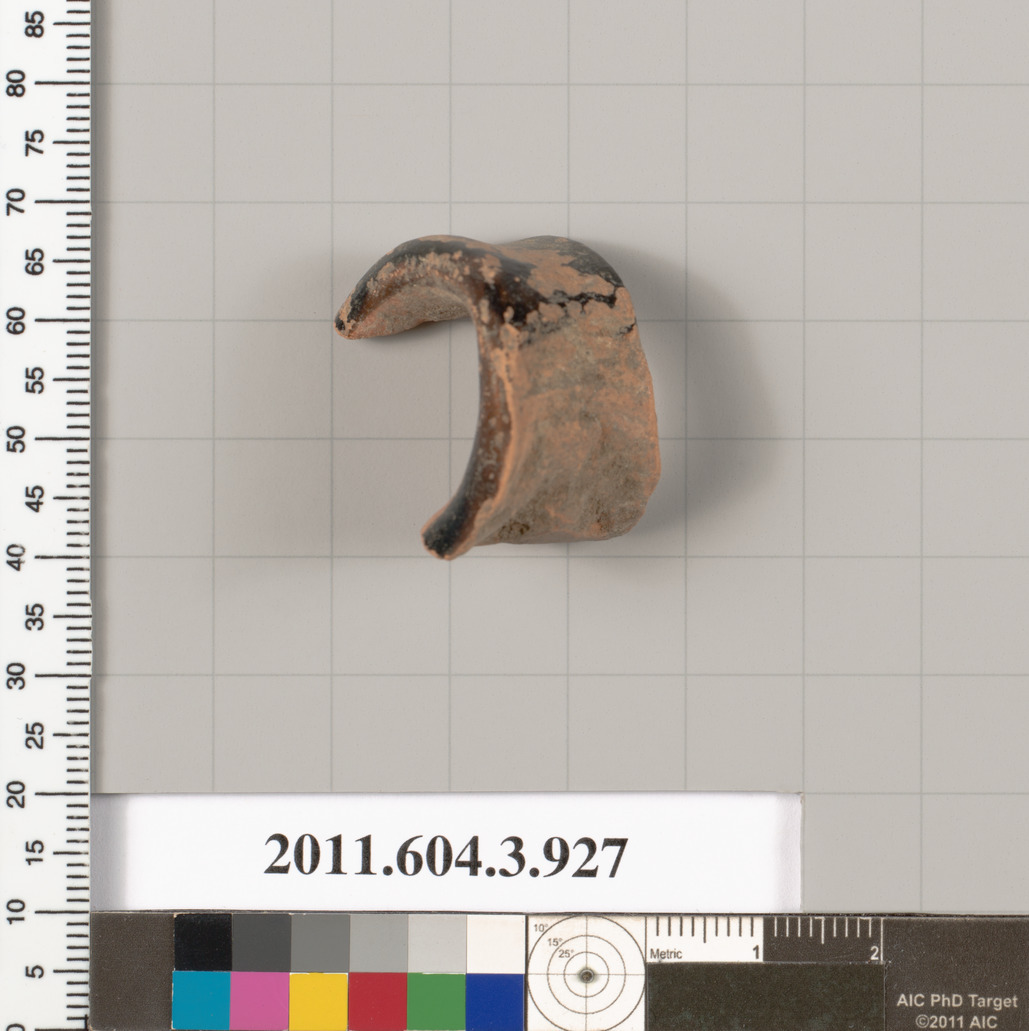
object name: lekythos fragment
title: Terracotta fragment of a lekythos (oil flask)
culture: greek, attic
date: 600-401 BCE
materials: terracotta